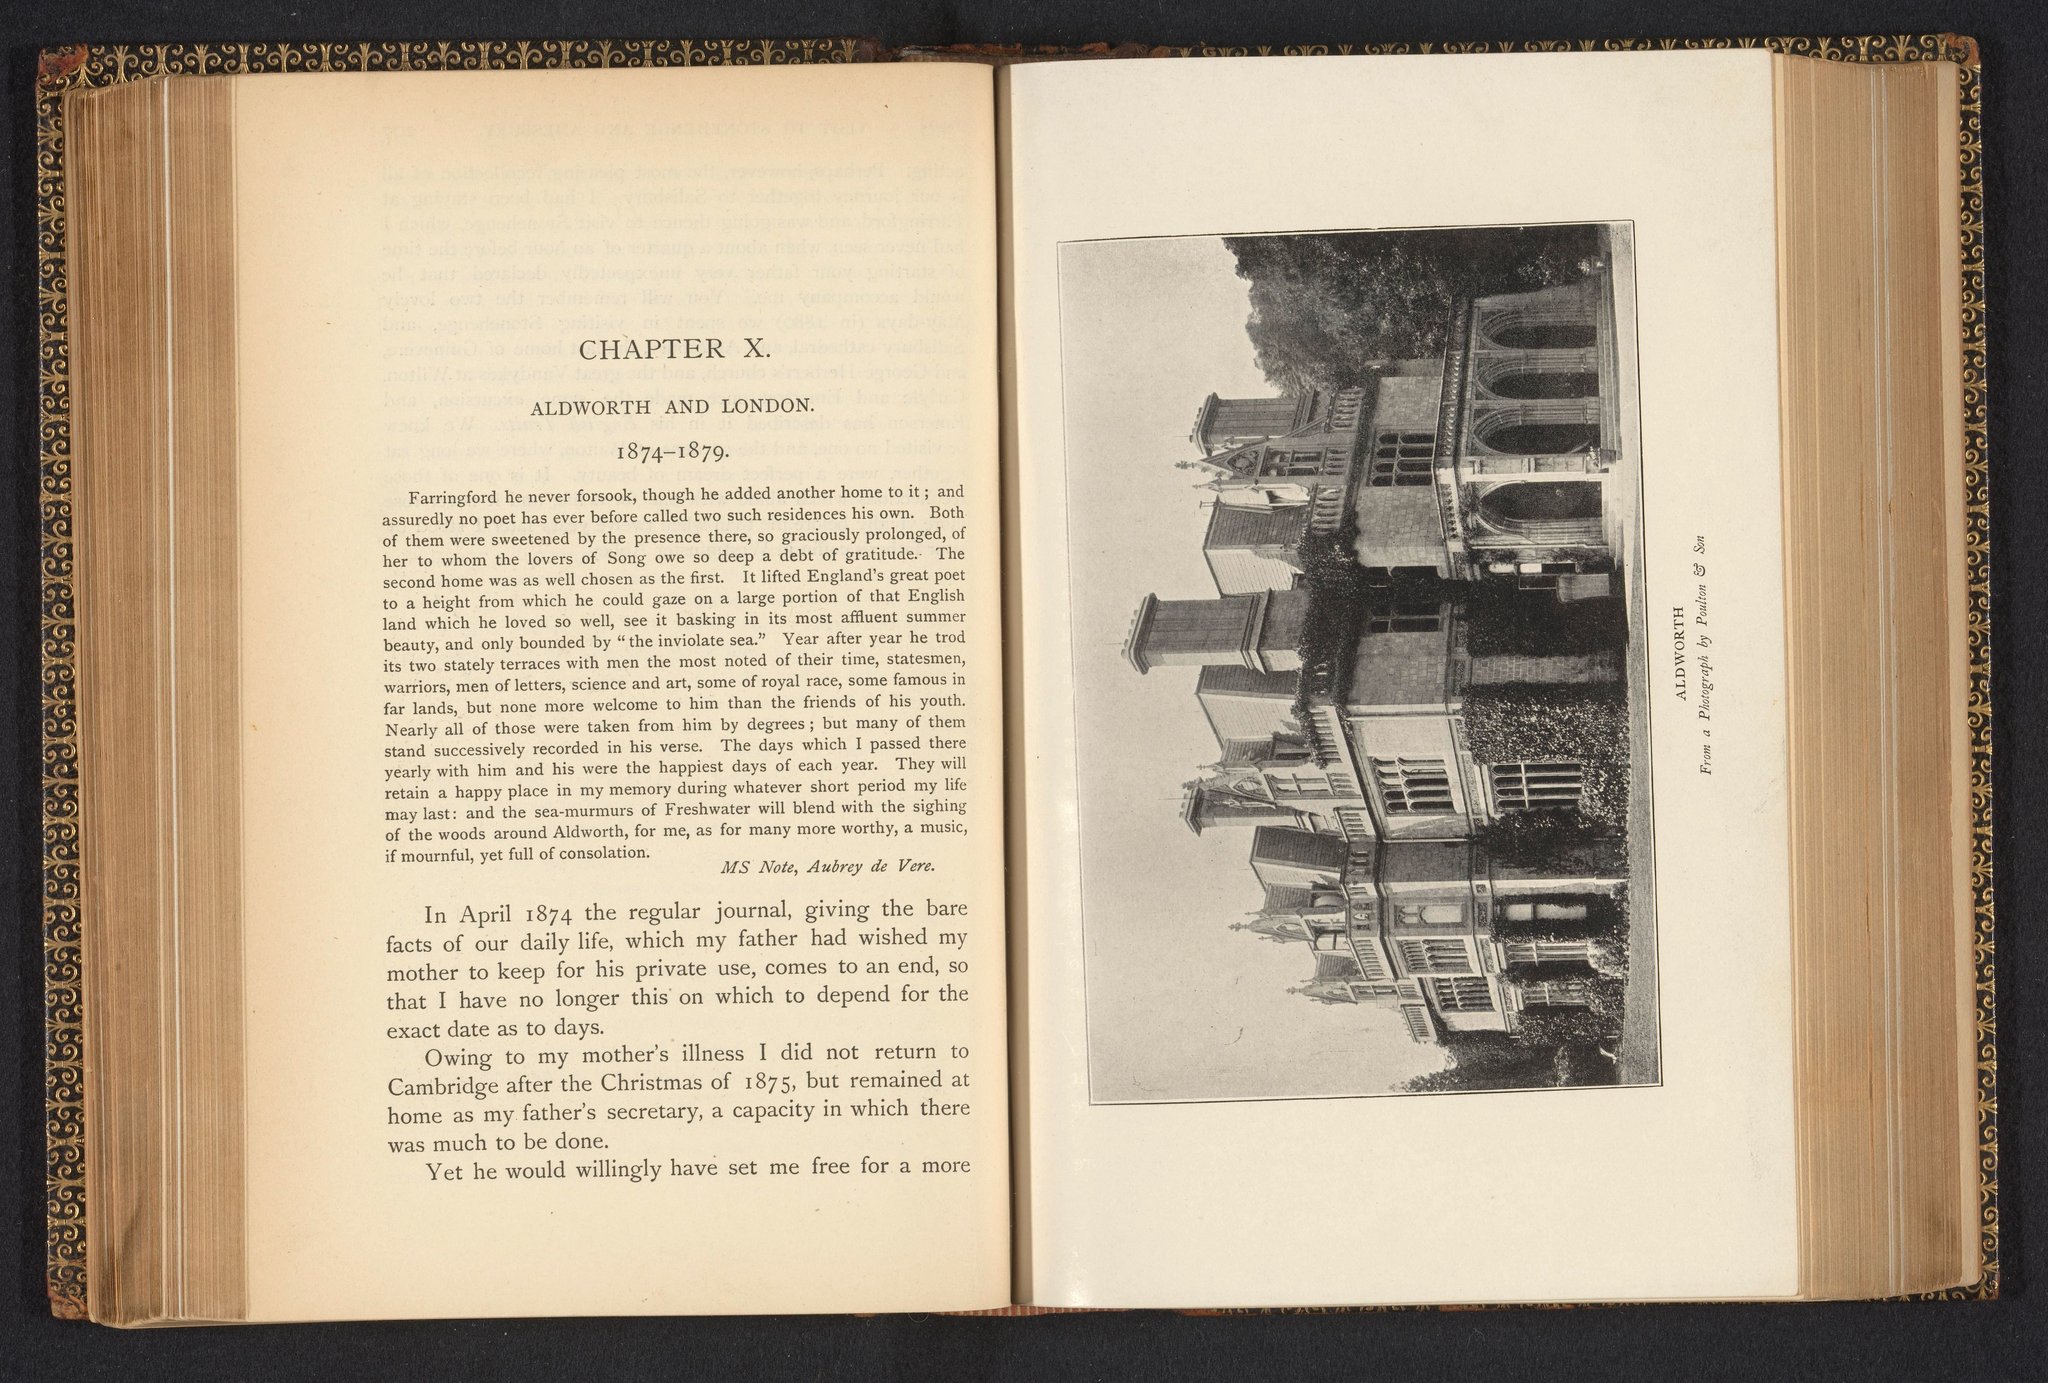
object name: page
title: Aldworth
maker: Anonymous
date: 1887-1897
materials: paper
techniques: autotype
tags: façade (of house or building), country-house